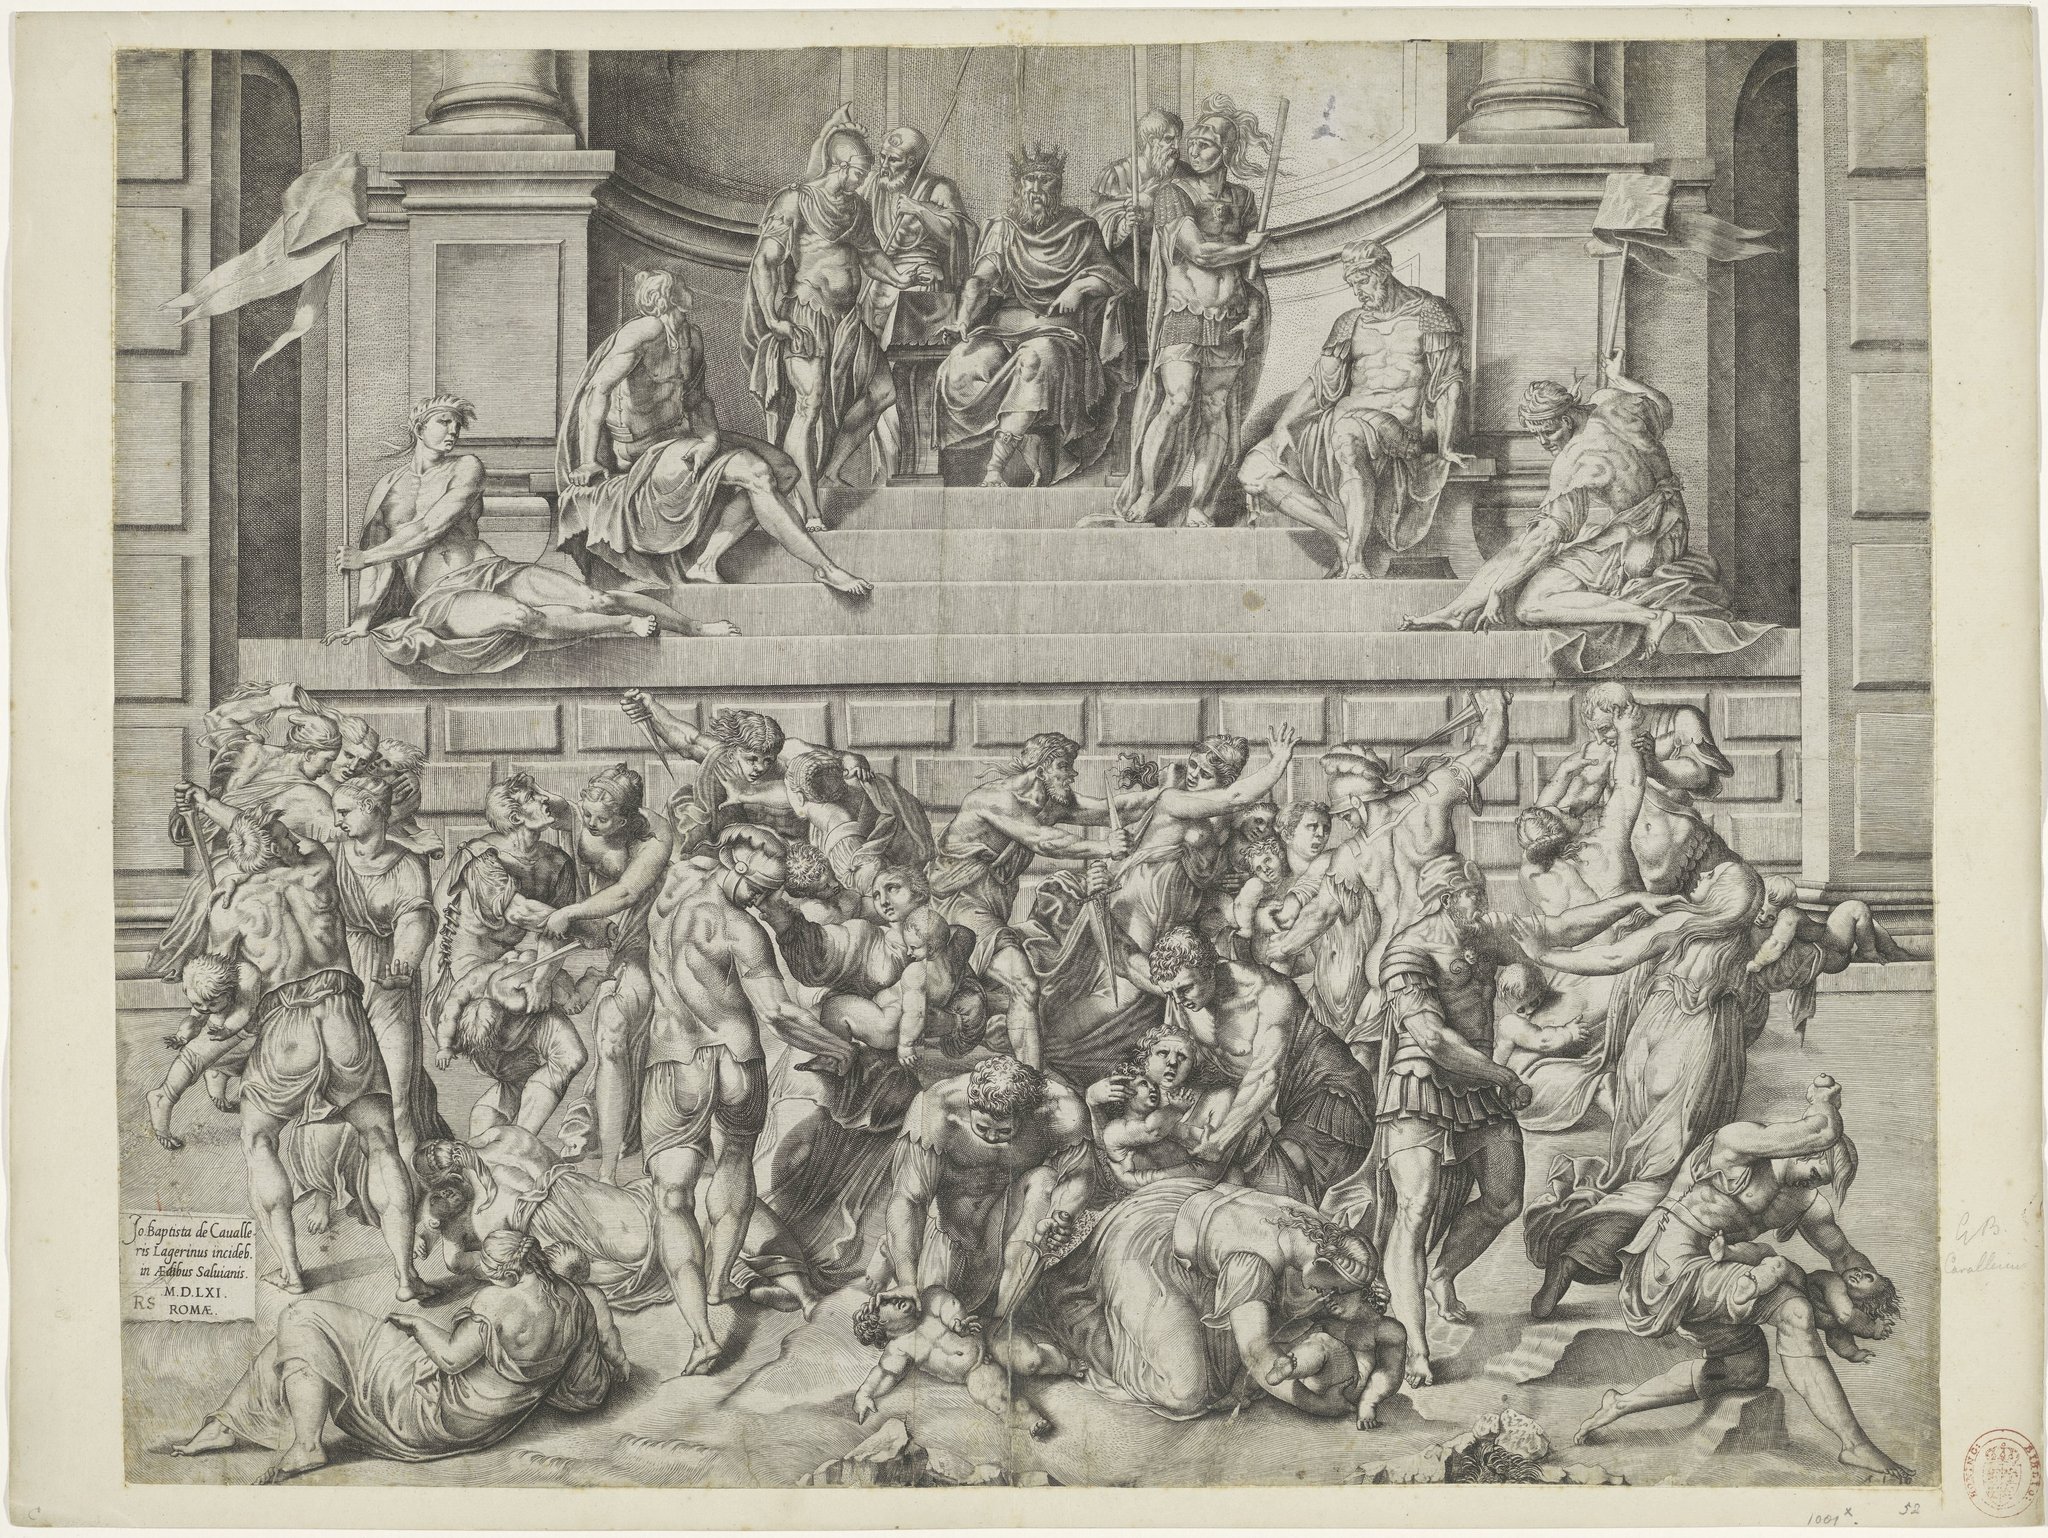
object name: print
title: Kindermoord te Betlehem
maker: giovanni battista de cavalieri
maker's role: print maker, printer, publisher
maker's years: 1525-1601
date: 1561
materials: paper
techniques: engraving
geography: rome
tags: the massacre ot the innocents; sometimes herod looking on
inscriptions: inscription: ‘RS’, collector's mark: Lugt 240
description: Wanhopige moeders proberen hun kinderen te beschermen tegen de soldaten van Herodes. Vanaf zijn troon, op een verhoging, kijkt Herodes toe op de gewelddadige praktijken.